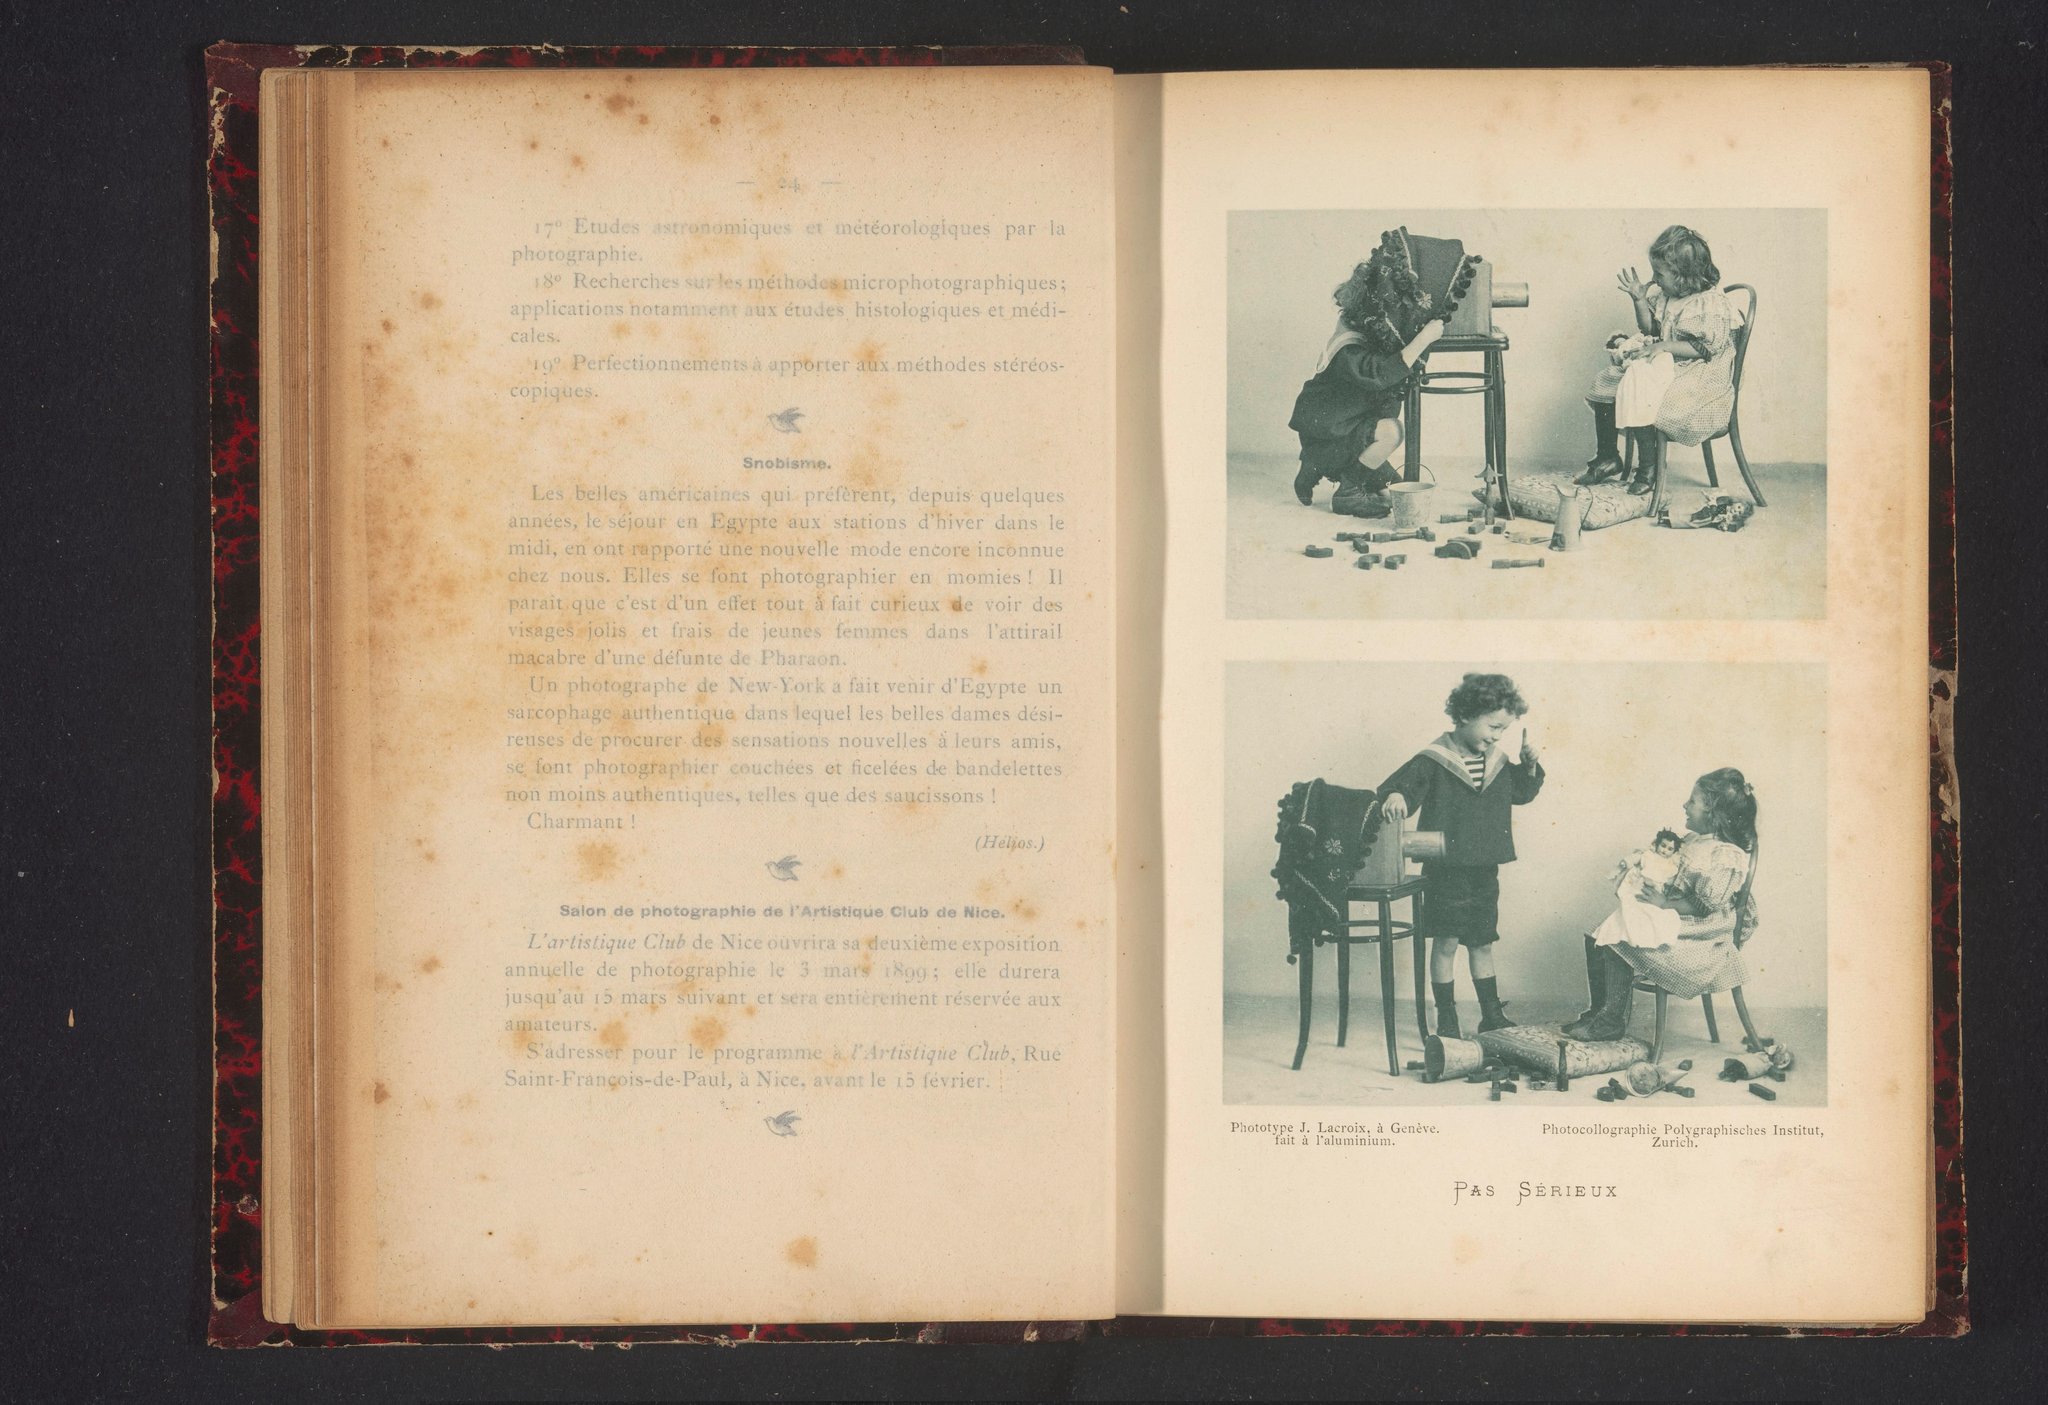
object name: photomechanical print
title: Jongetje regisseert een meisje op een stoel om een foto van haar te kunnen maken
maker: j. lacroix (fotograaf)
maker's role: painter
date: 1894-1899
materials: paper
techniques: autotype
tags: camera ~ photography, boy (child between toddler and youth), girl (child between toddler and youth)